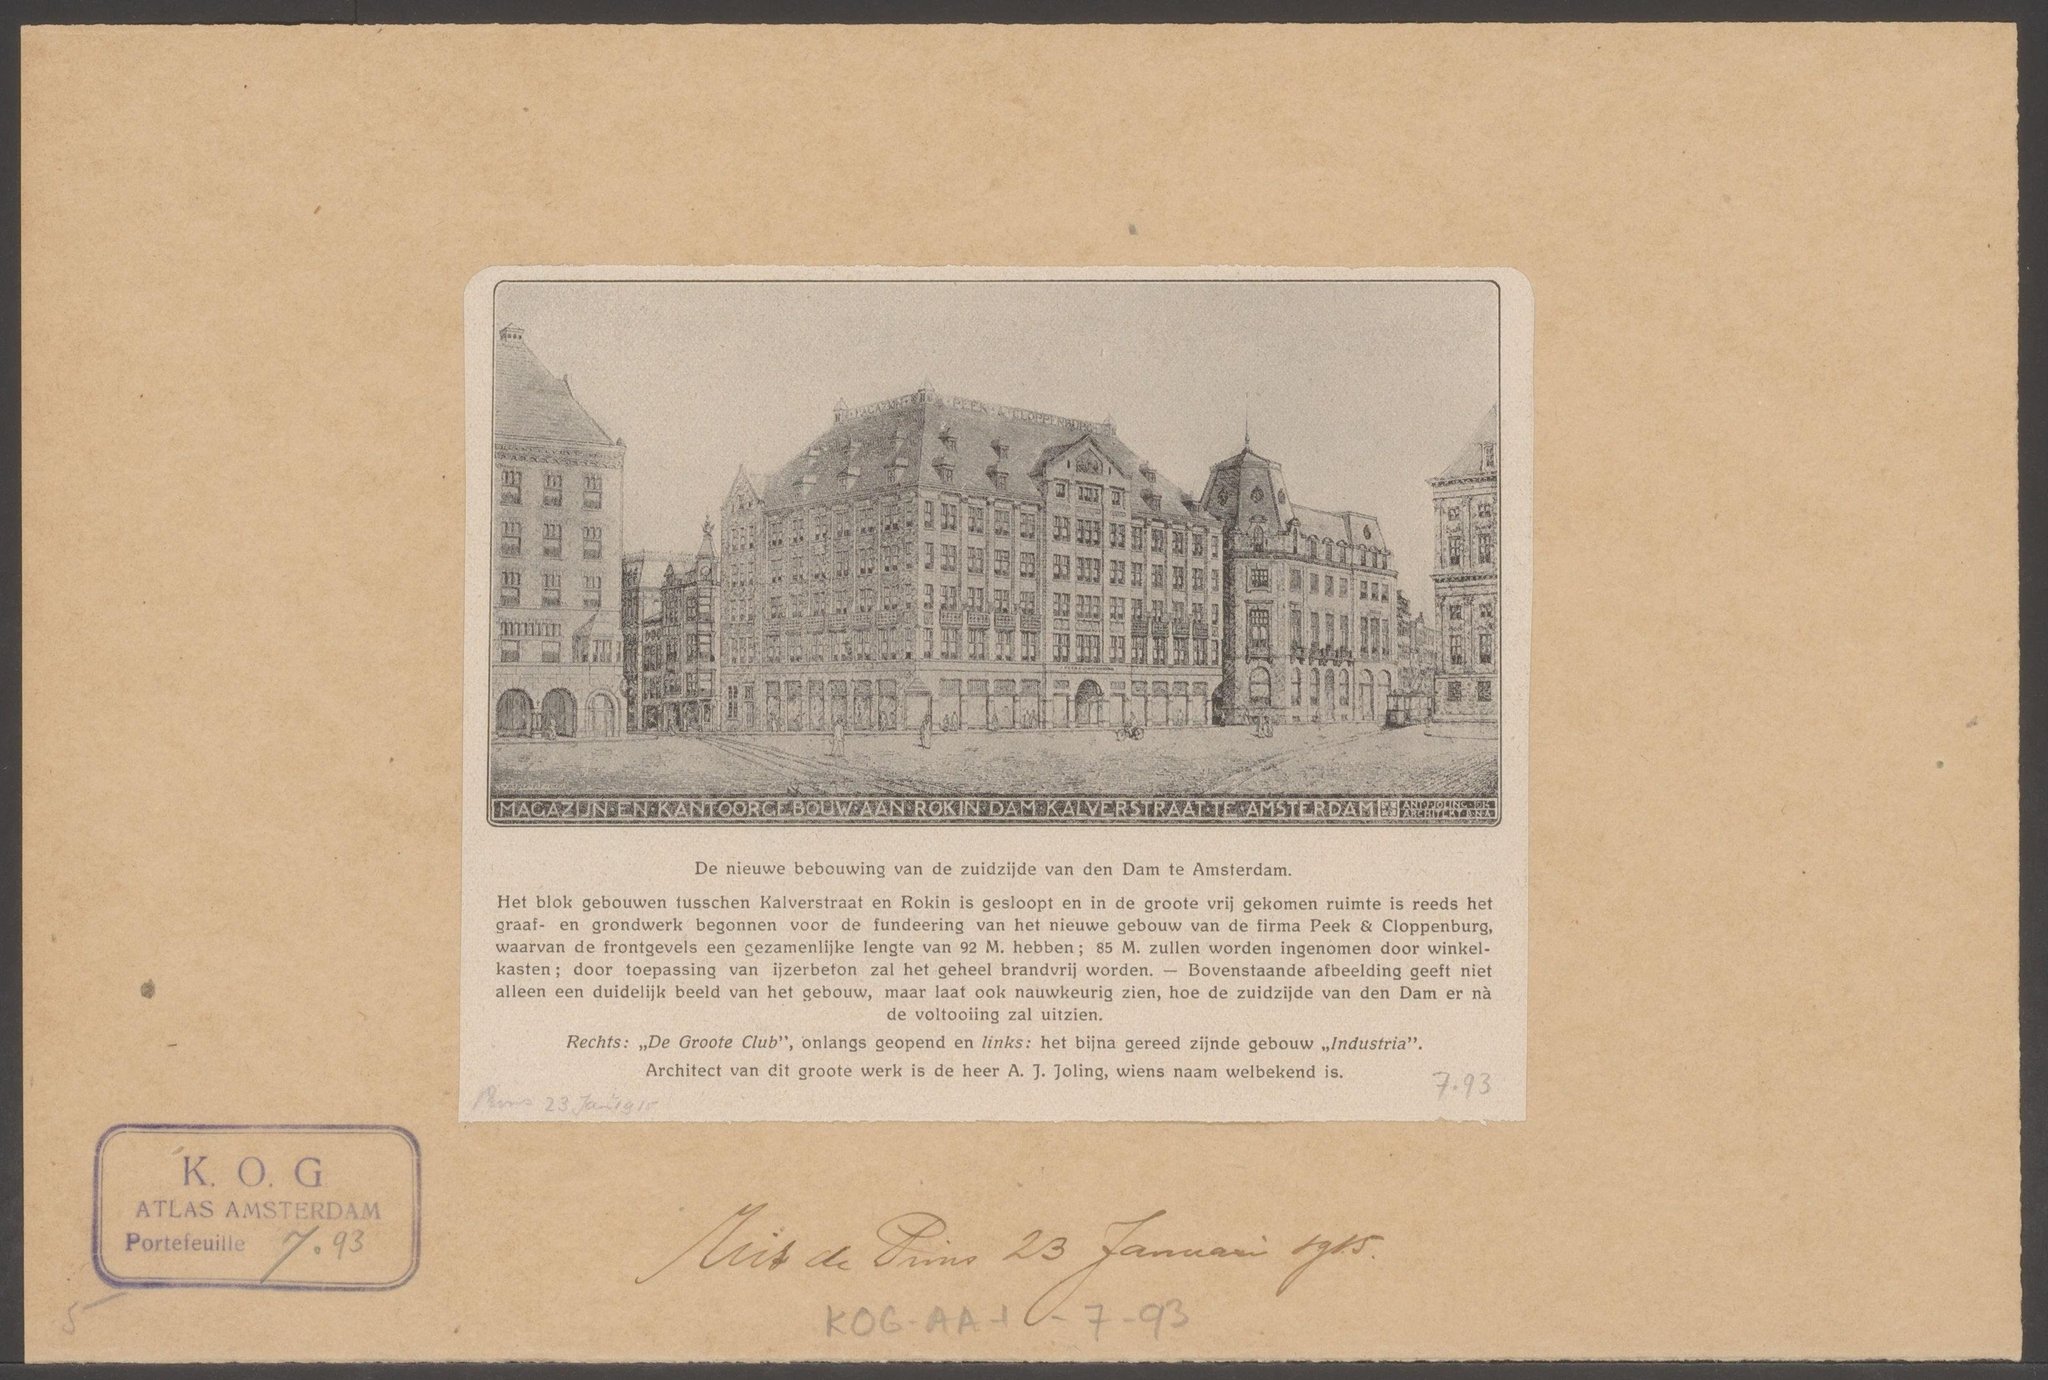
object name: photomechanical print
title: Gezicht op het pand van Peek & Cloppenburg op de Dam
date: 1915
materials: paper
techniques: letterpress printing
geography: amsterdam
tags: square, place, circus, etc., city-view in general; 'veduta', façade (of house or building)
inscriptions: collector's mark: ‘7’ Lugt 1641b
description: Fotomechanische afdruk uit: De Prins (1915), 23 januari 1915.